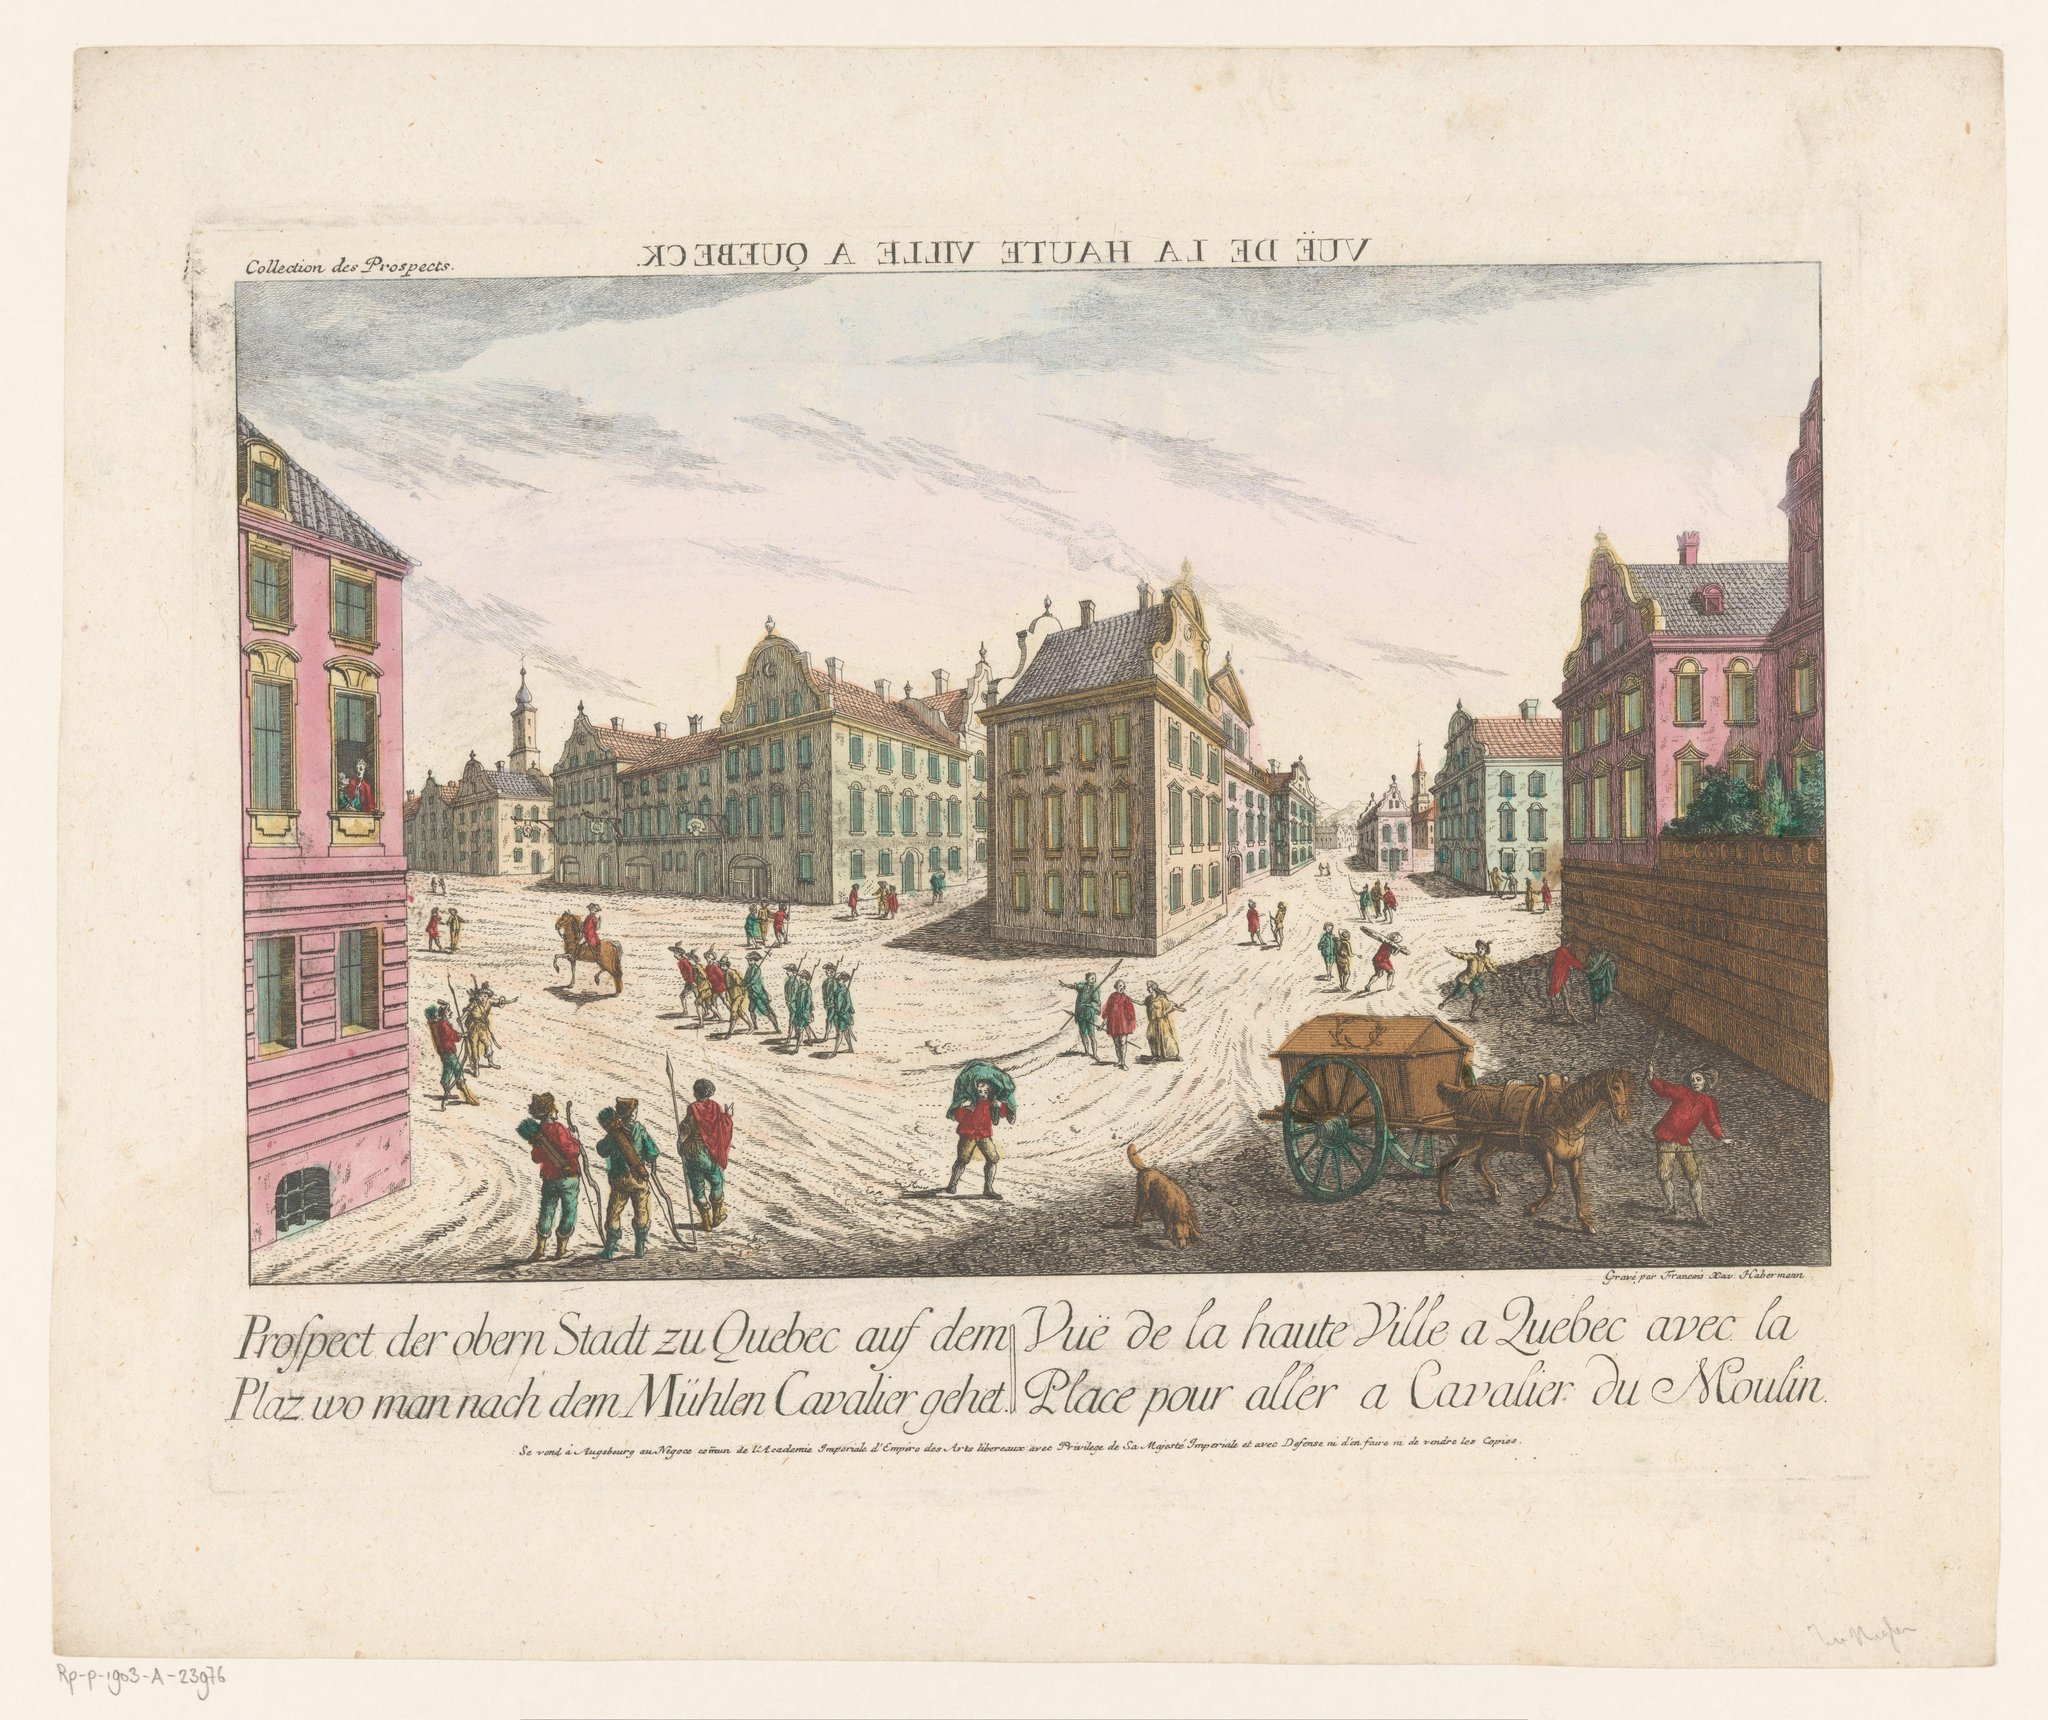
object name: opticaprent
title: Gezicht op een buitenwijk te Québec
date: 1755-1779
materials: paper, watercolor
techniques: brush, etching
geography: augsburg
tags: city-view, and landscape with man-made constructions, four-wheeled, animal-drawn vehicle, e.g.: cab, carriage, coach, québec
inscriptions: collector's mark: Lugt 2228